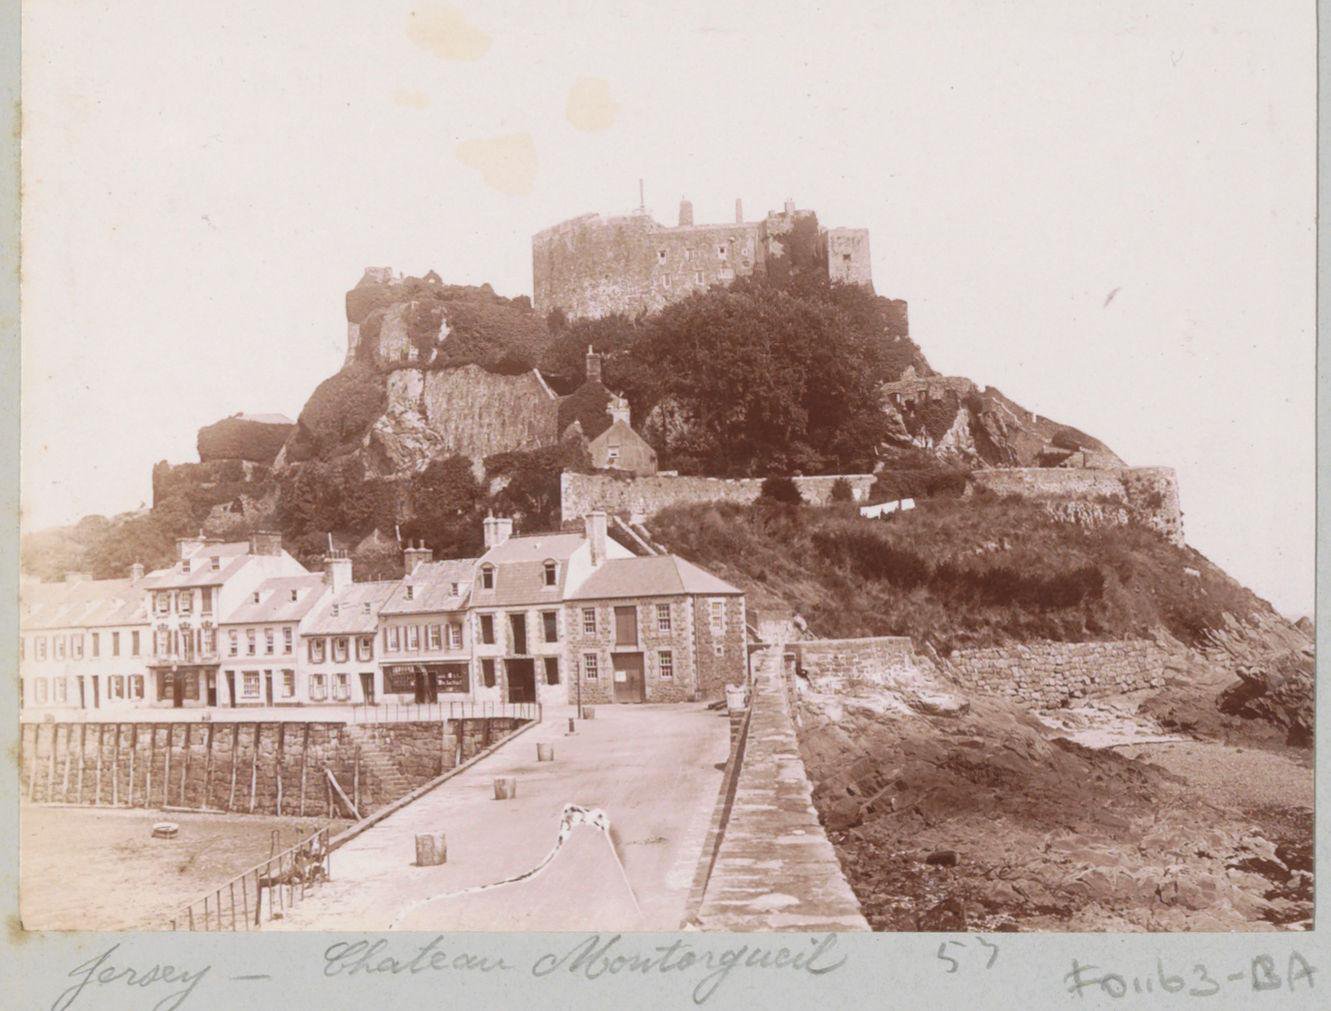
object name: photograph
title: Gezicht op het Château de Mont-Orgueil (Gorey Castle) op Jersey met op de voorgrond een huizenrij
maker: delizy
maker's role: manufacturer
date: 1896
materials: paper, photographic support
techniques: gelatin silver print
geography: jersey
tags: prospect of village, silhouette of village, castle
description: Onderdeel van Fotoalbum van een Franse amateurfotograaf met opnames van uitstapjes in Frankrijk, Spanje, België, Luxemburg en Nederland, de eerste automobielen en autoraces.